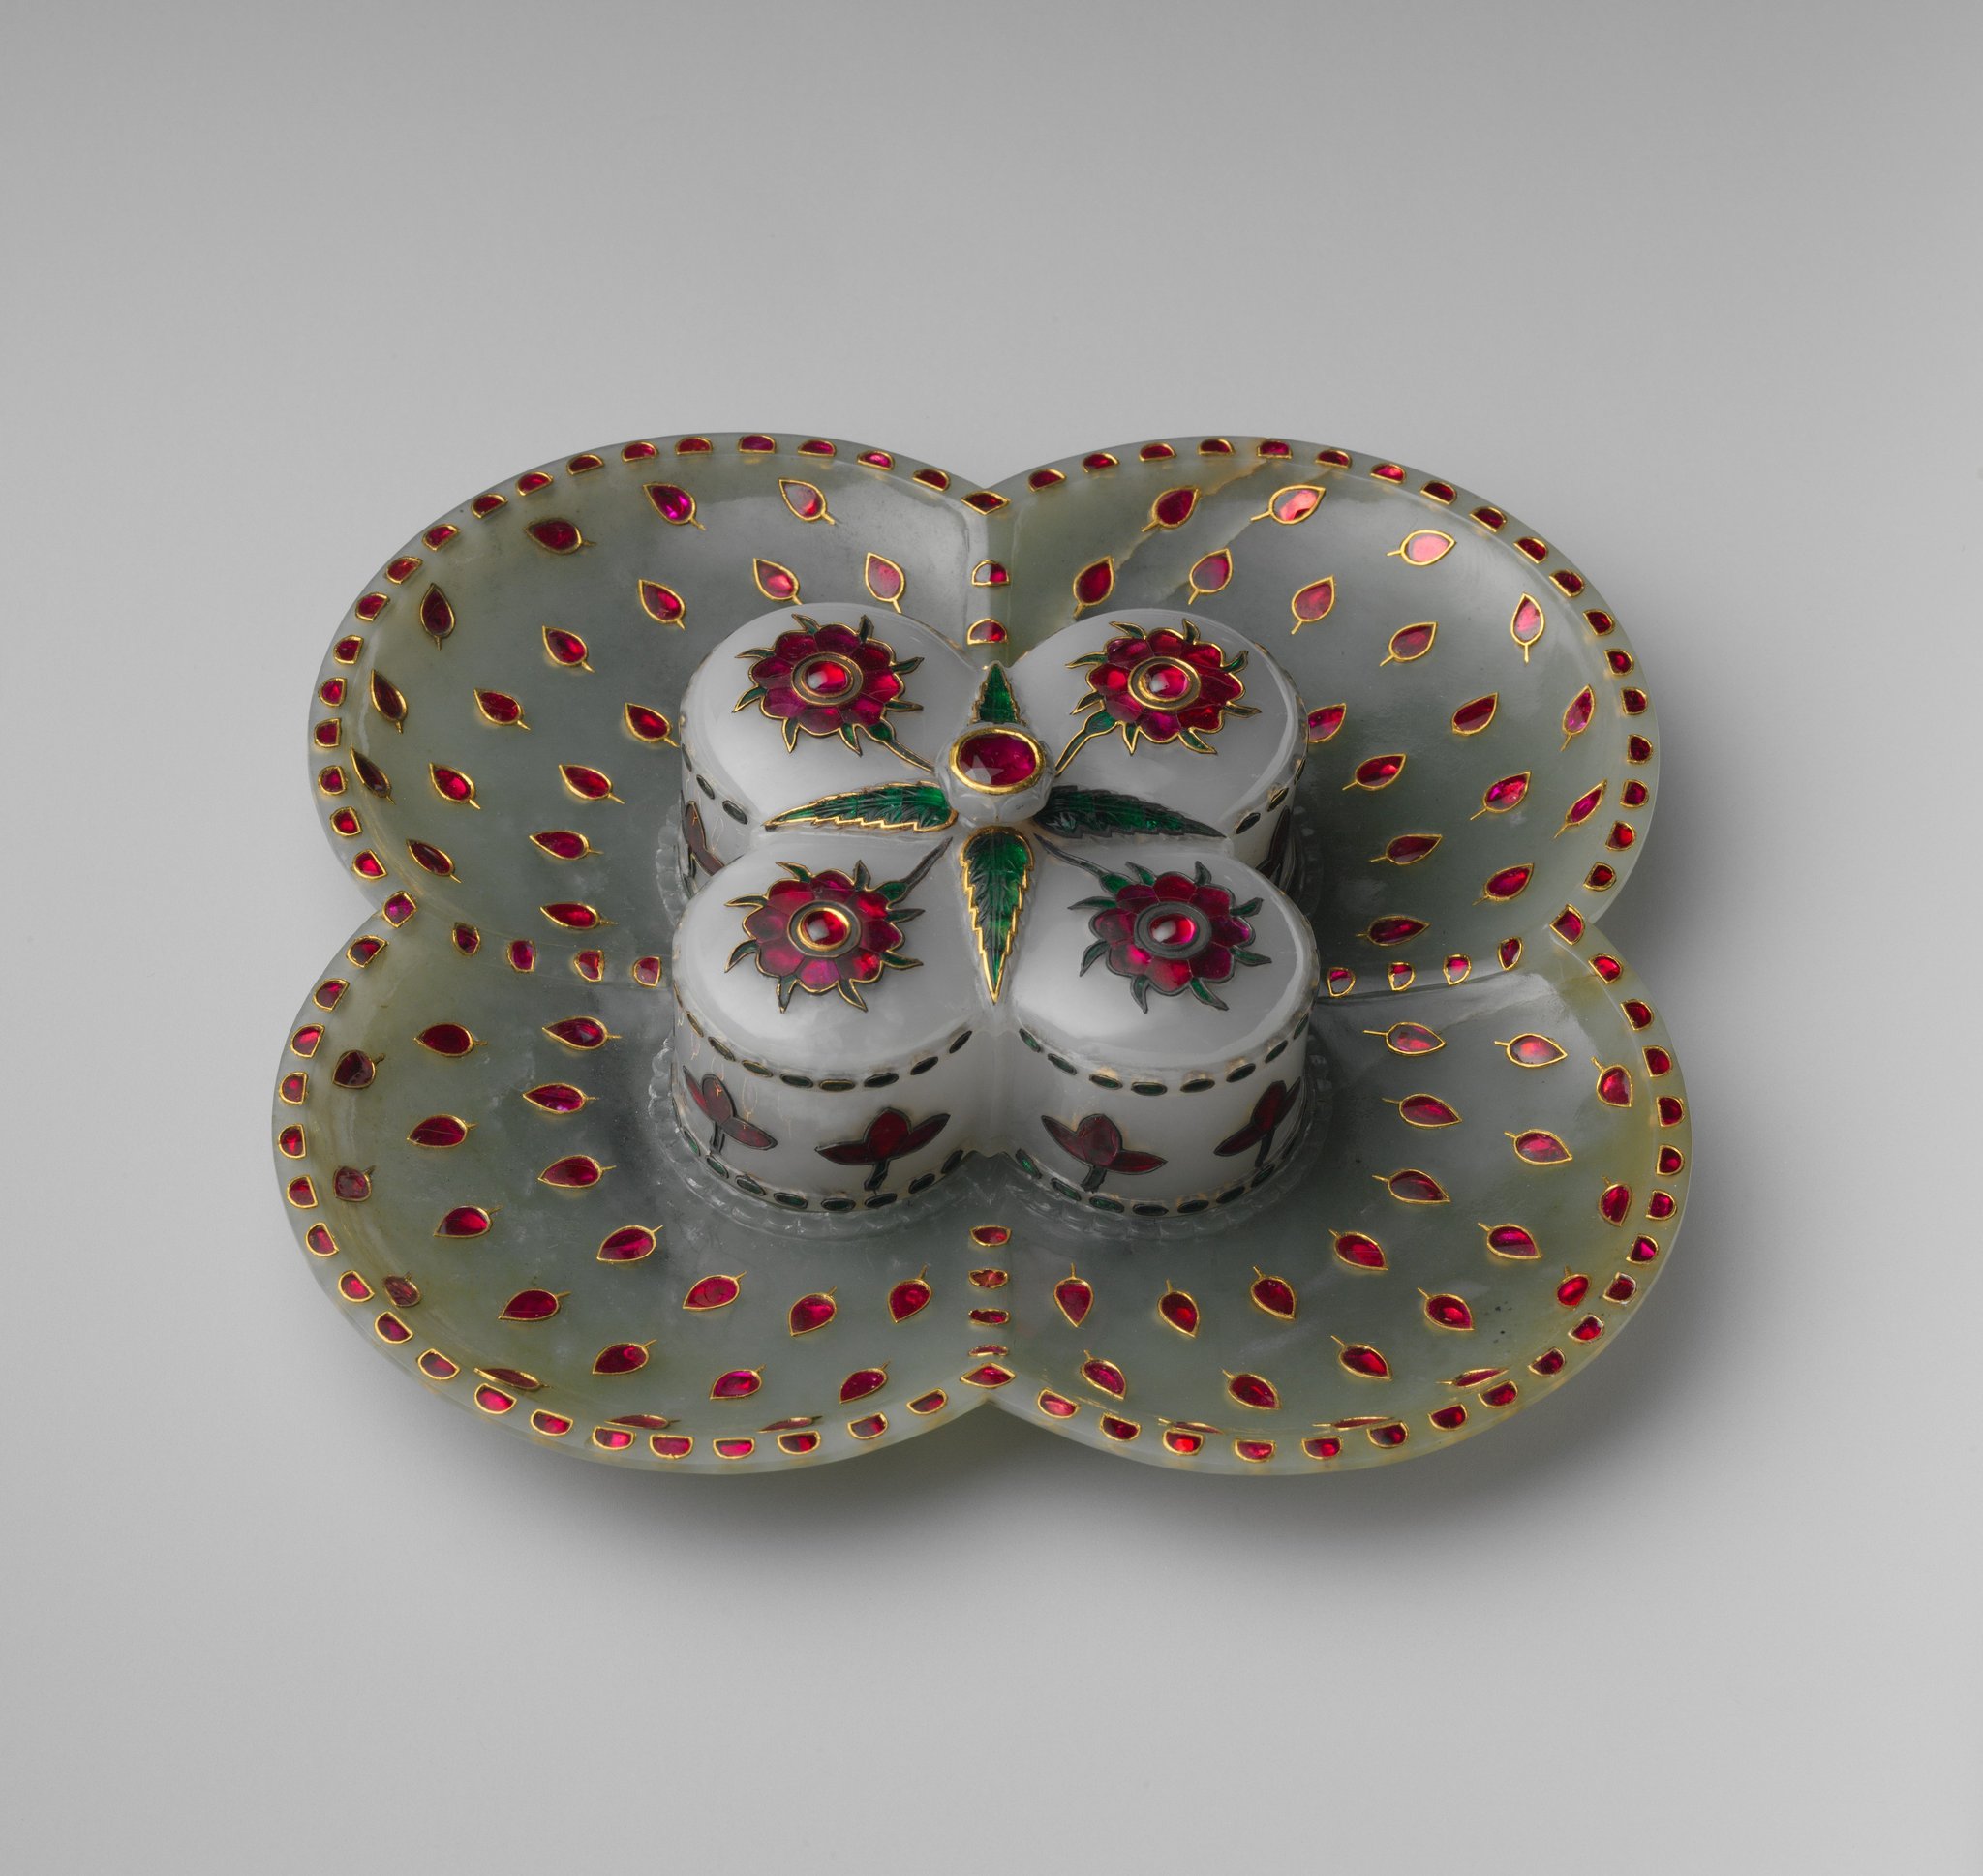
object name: box with tray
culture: indian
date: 1701-1900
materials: gold, jade, stone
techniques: inlay